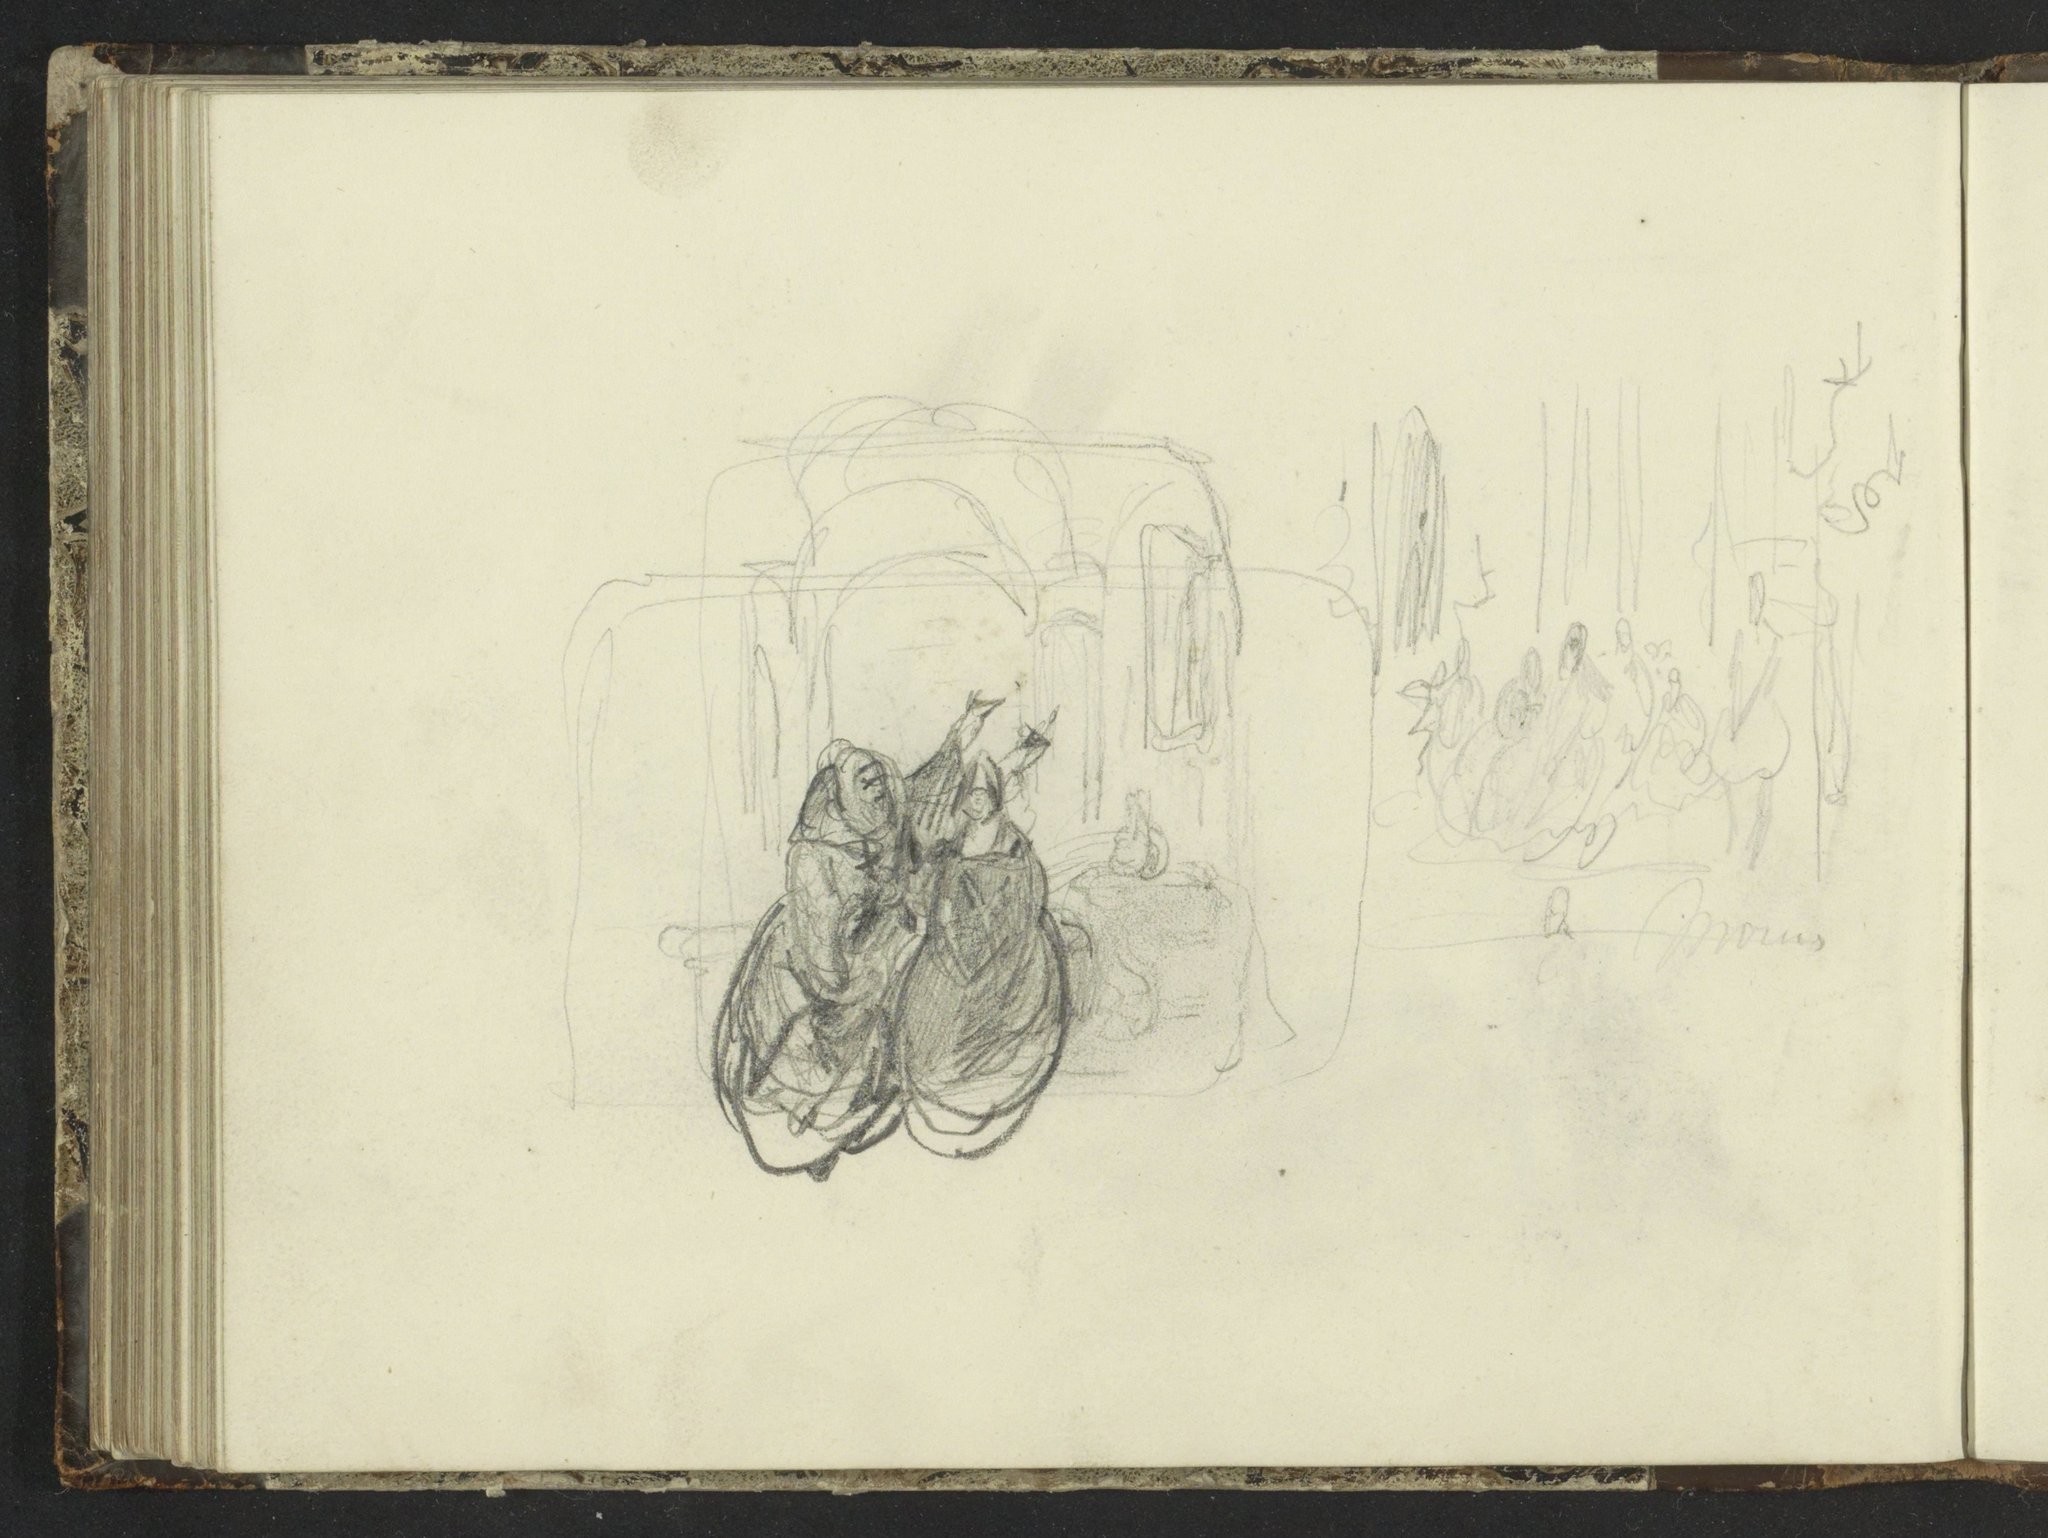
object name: sketchbook leaf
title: Monnik en vrouw in een interieur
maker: willem hendrik schmidt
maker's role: draughtsman, painter, print maker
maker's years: 1809-1849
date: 1819-1849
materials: paper, pencil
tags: monk(s), friar(s), architecture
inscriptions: annotation: ‘mou[...]’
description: De monnik houdt de linkerarm boven de vrouw. Tevens een studie van figuren tegen een architecturale achtergrond. Blad 51 verso uit een schetsboek met 58 bladen.